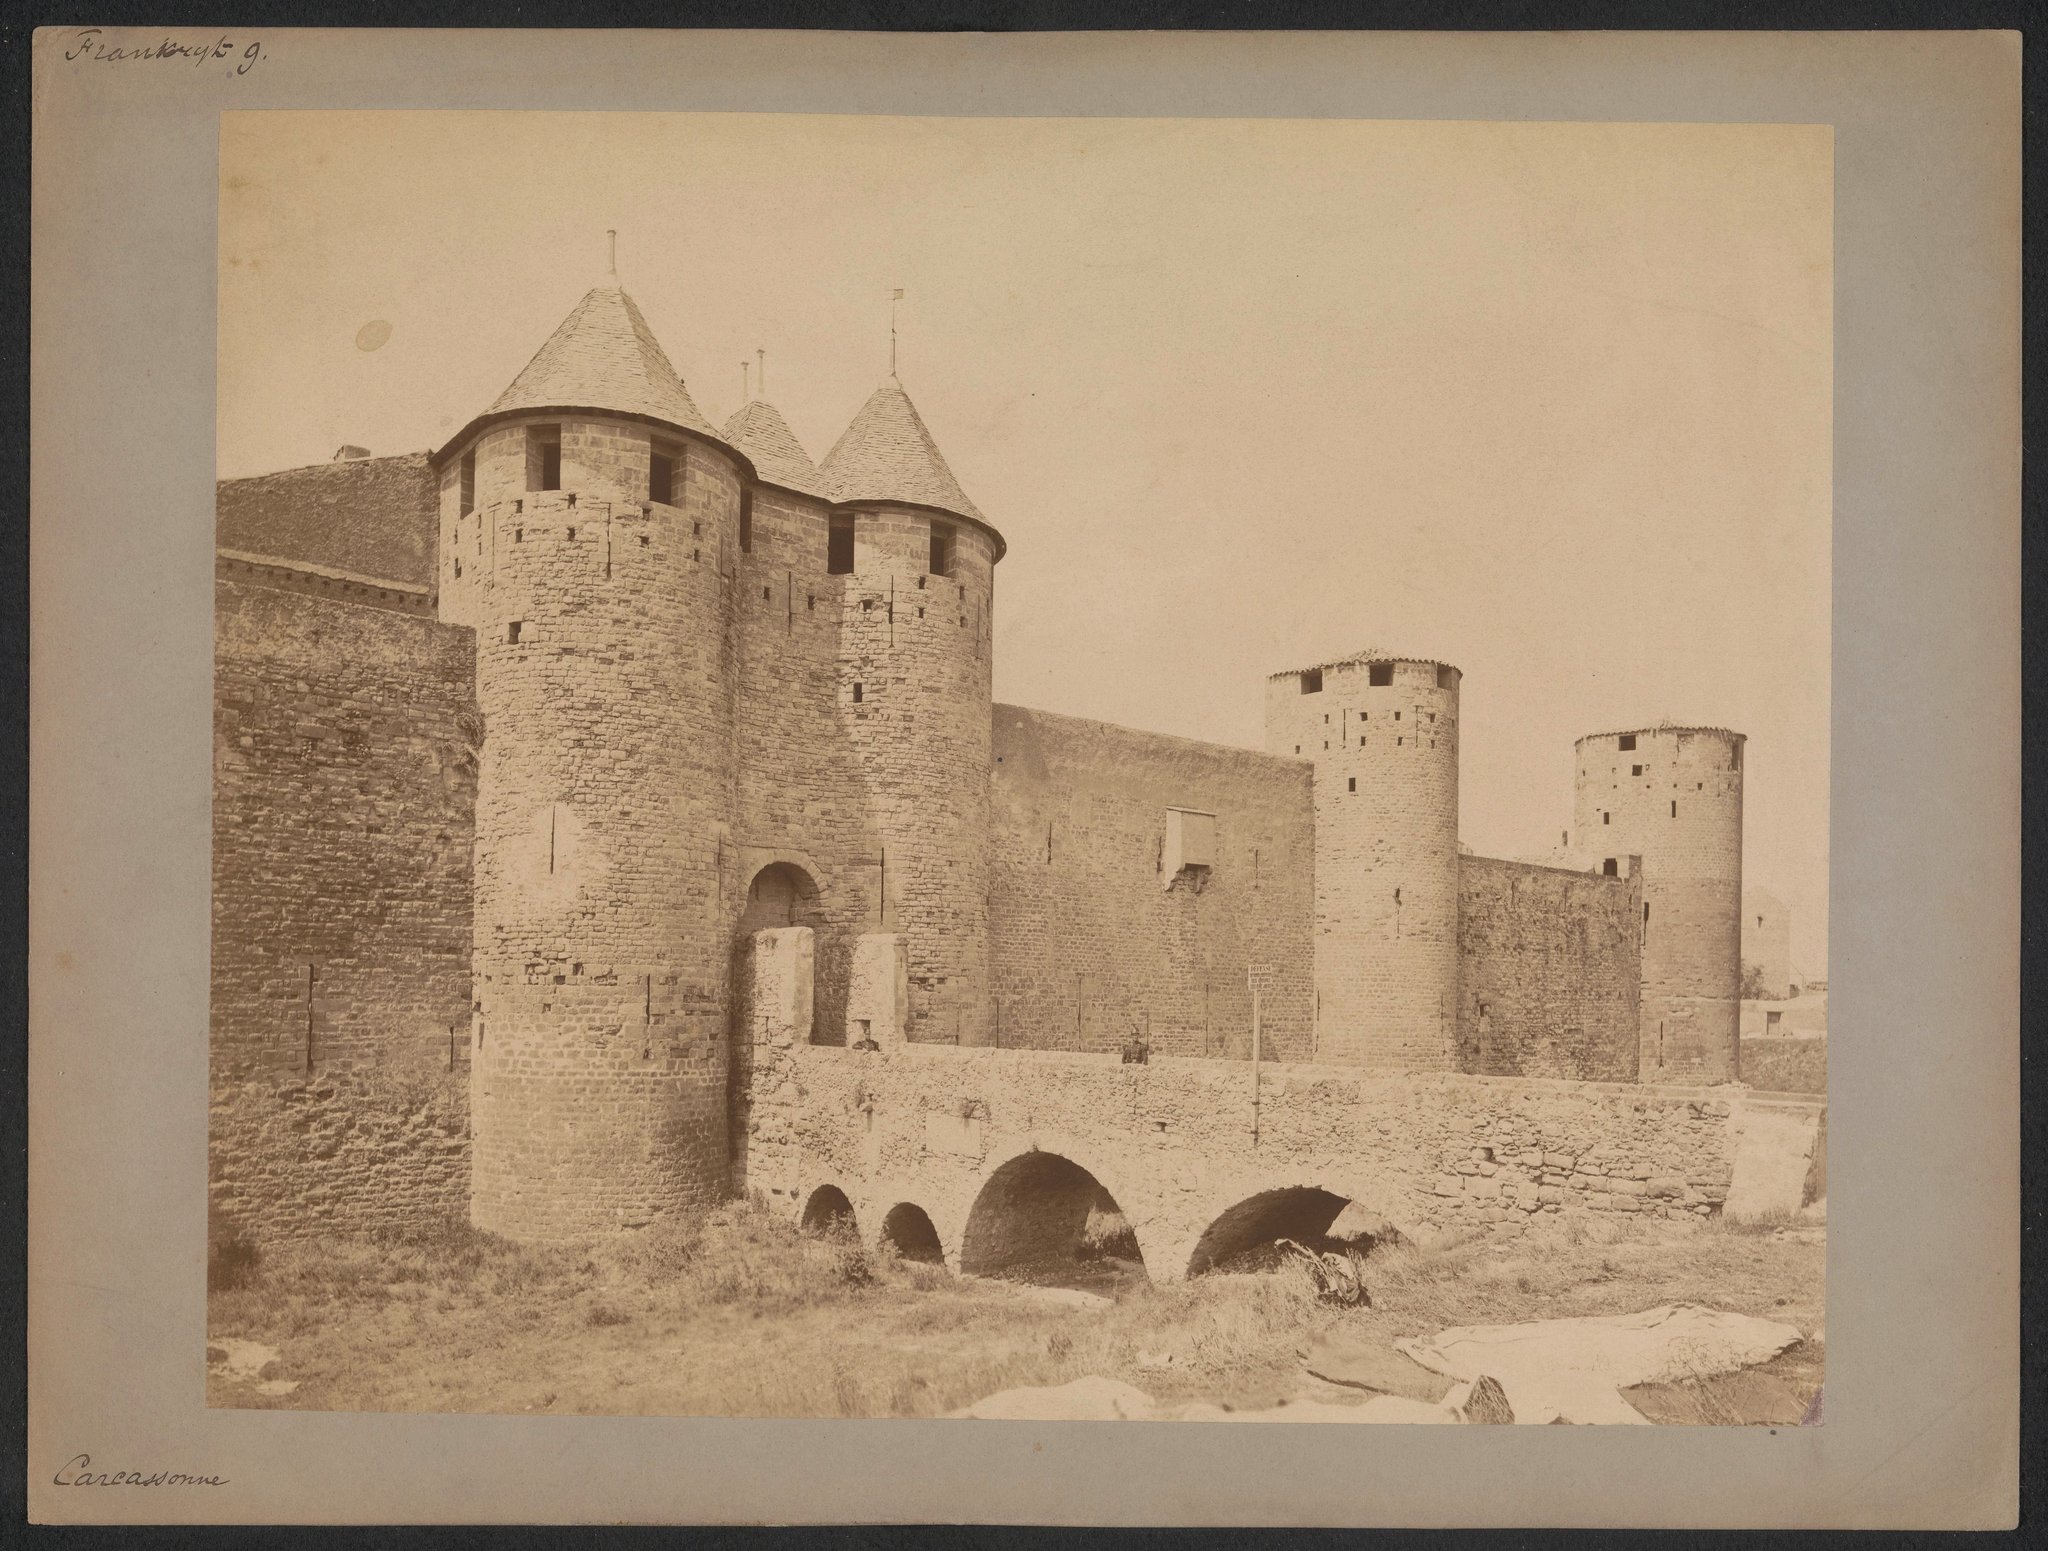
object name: photograph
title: Deel van de vesting van Carcassonne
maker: Anonymous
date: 1850-1900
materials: cardboard, photographic support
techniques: albumen print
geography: carcassonne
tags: fortress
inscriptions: annotation: ‘Frankrijk 9.’, collector's mark: ‘RIJKS NORMAALSCHOOL voor T[EEKENONDERWIJZERS] AMSTERDAM’, annotation: ‘Carcasone/ Entrée [....]pale/ du château’, annotation: ‘Carcassonne’, annotation: ‘Carcasone’